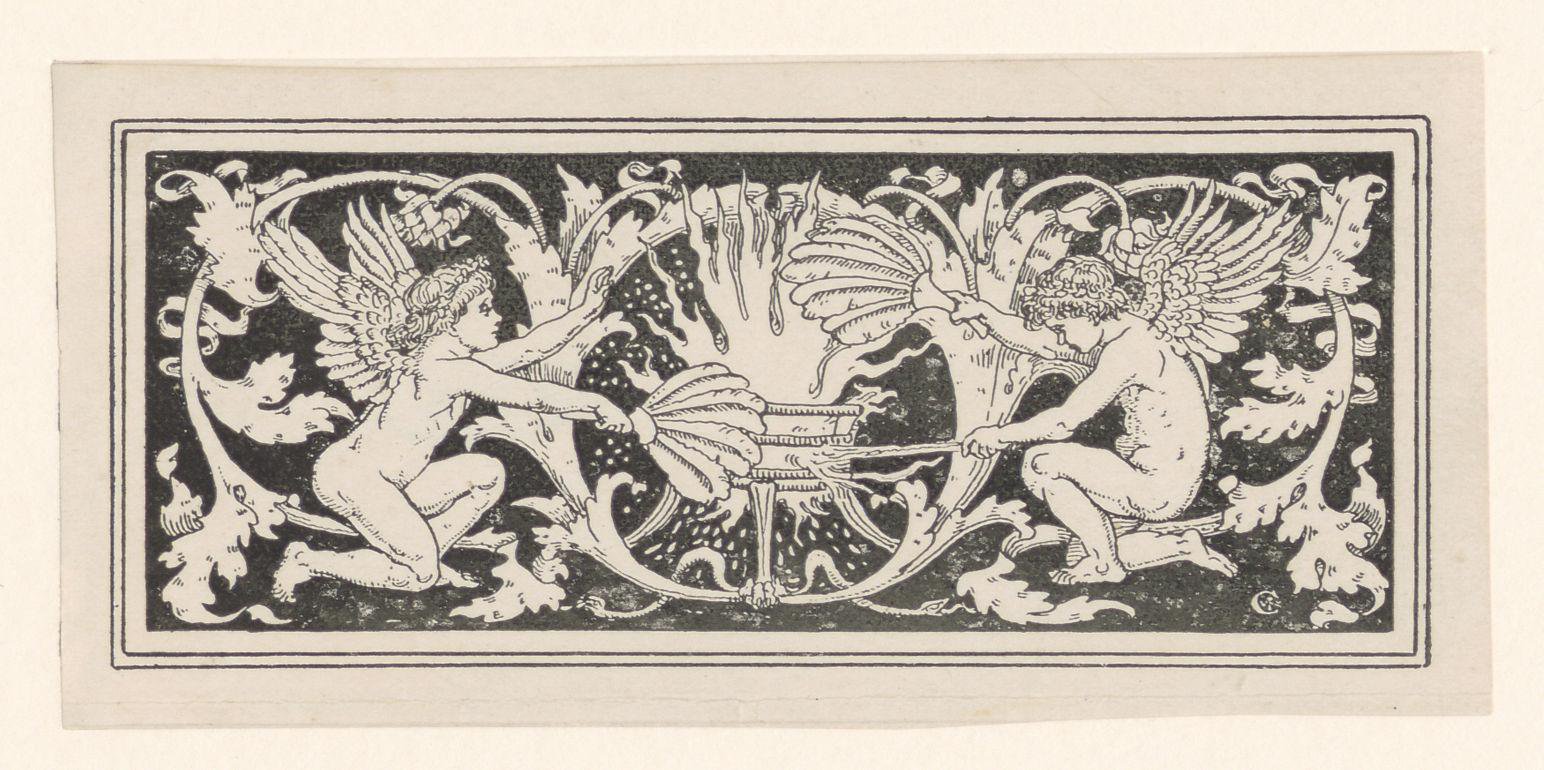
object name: print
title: Twee putti bij een vuurkorf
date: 1887-1893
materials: paper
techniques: engraving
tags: stirring up a fire, foliage ~ ornament, cupids: 'amores', 'amoretti', 'putti'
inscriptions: collector's mark: Lugt 2228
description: De prent is gebruikt in: Crane, Walter. The claims of decorative art. Londen: Lawrence & Bullen, 1892.